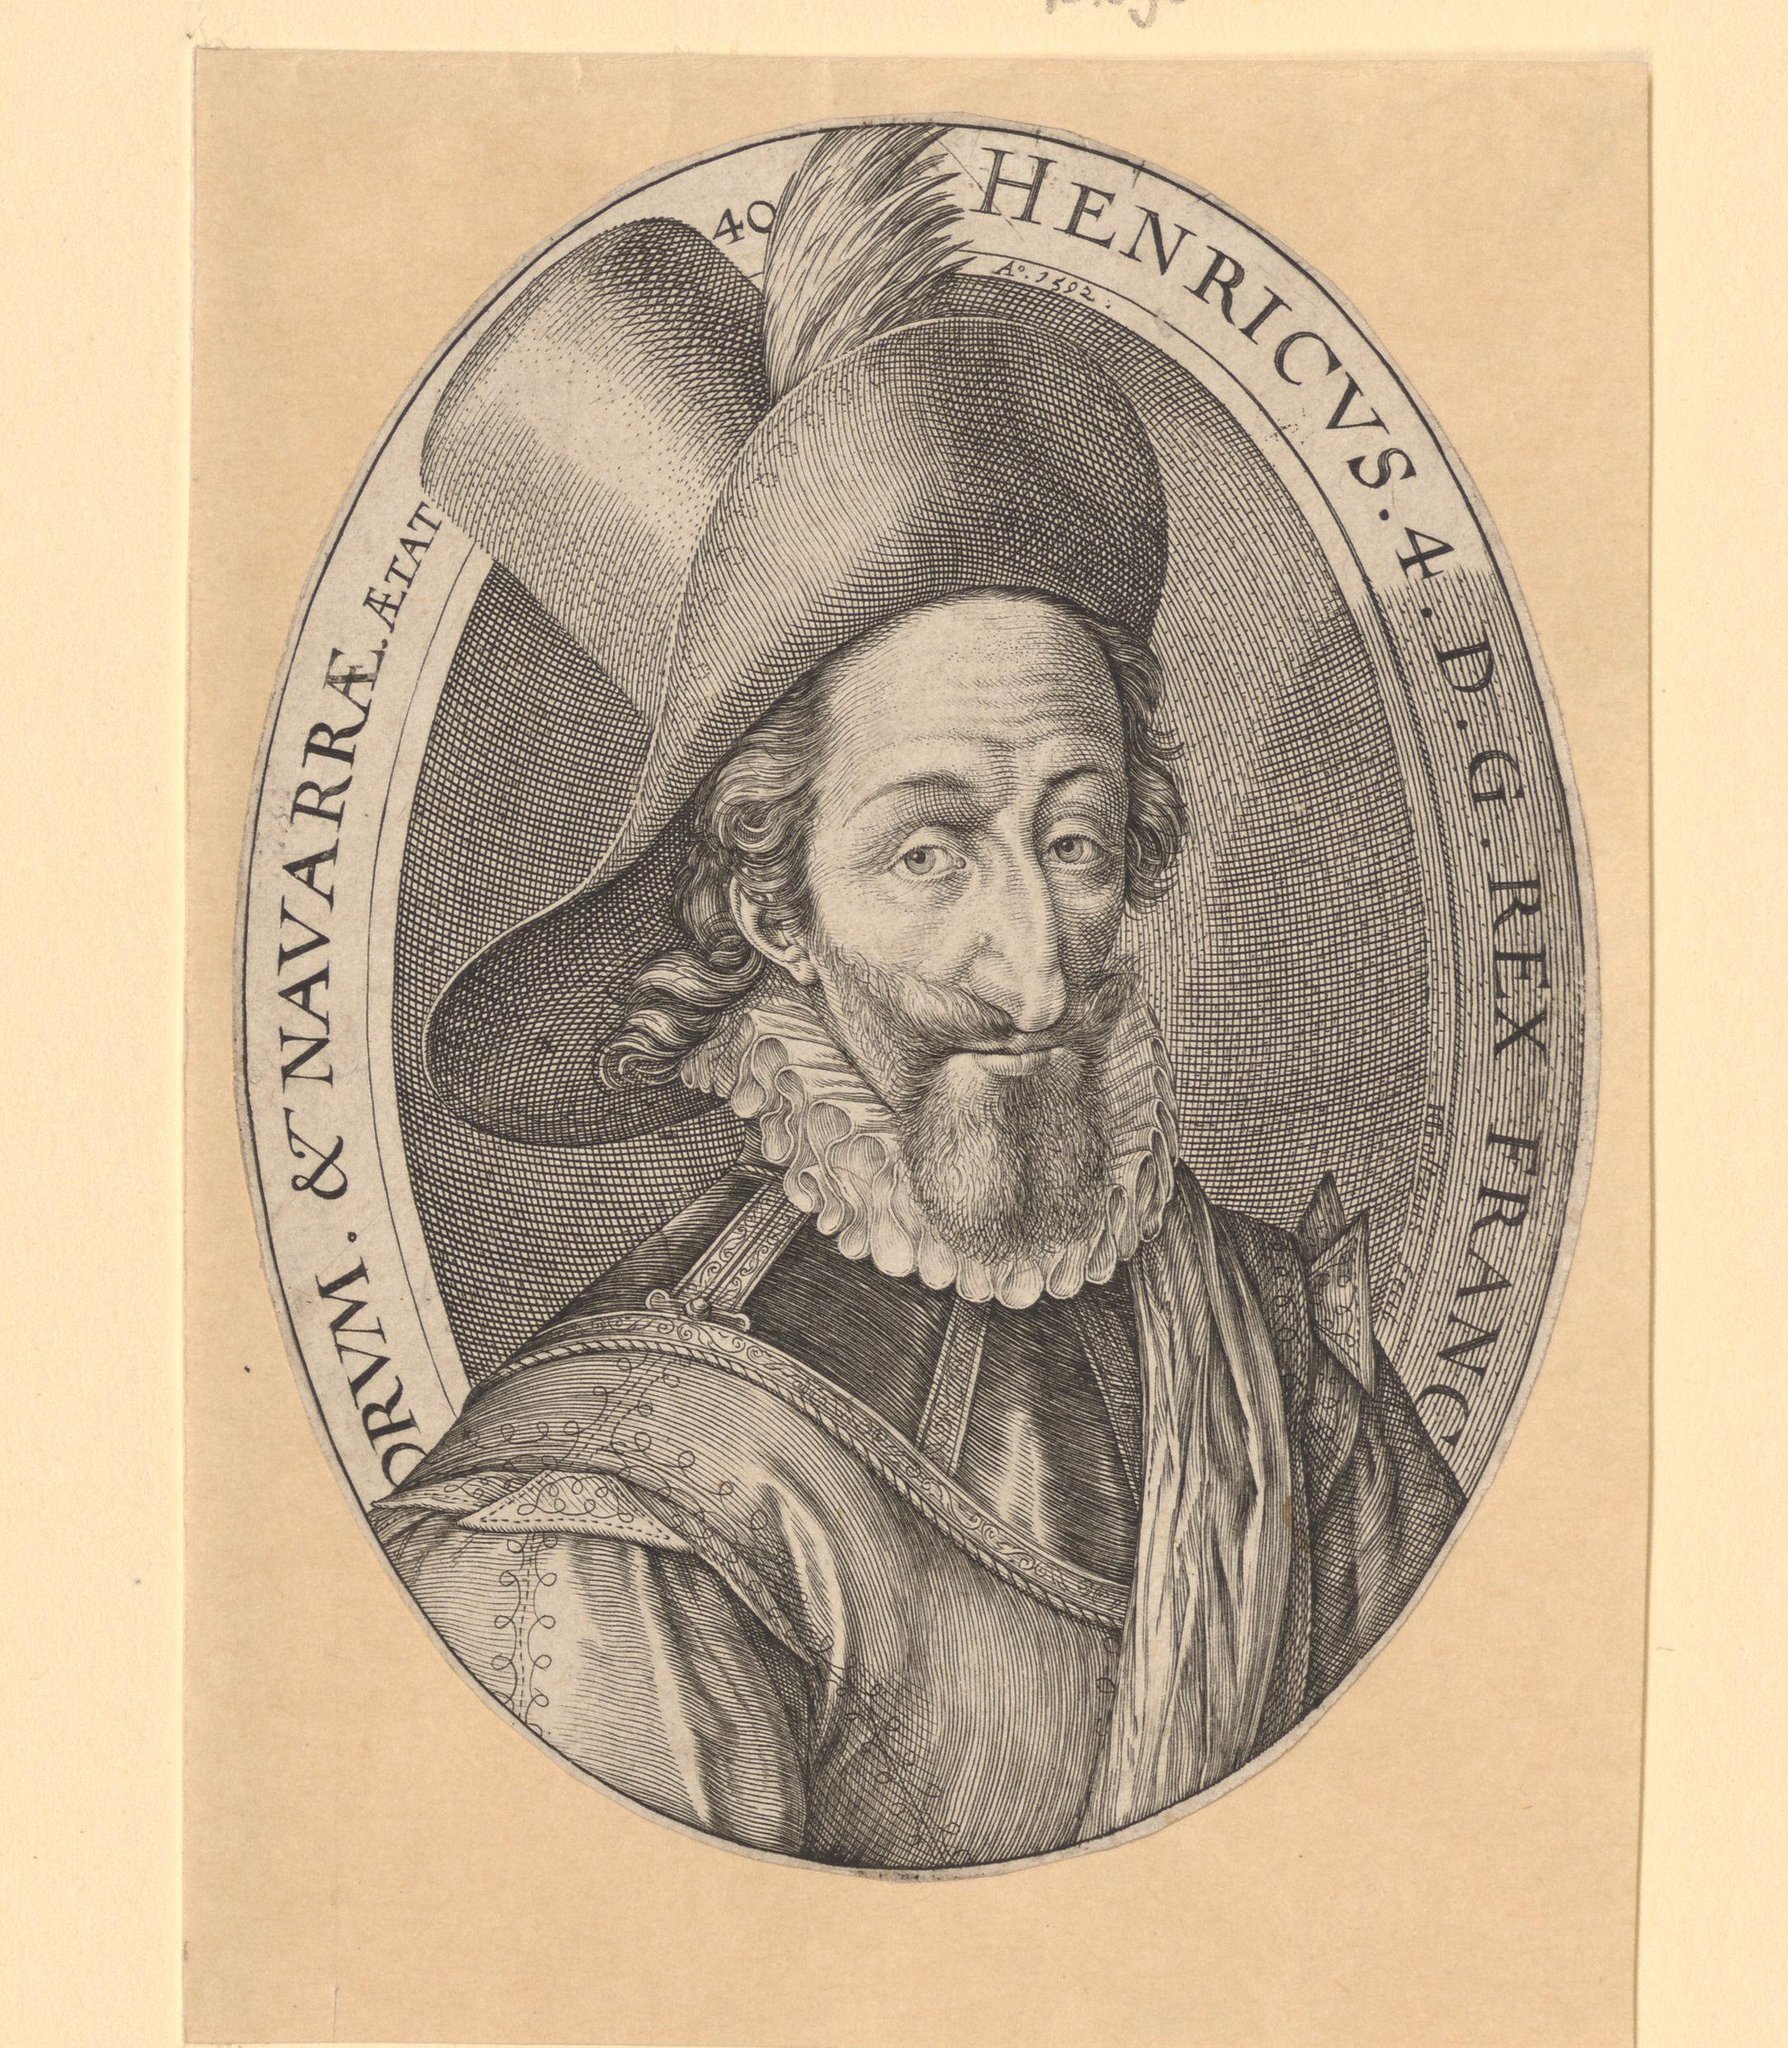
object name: print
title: Portret van Hendrik IV, koning van Frankrijk en Navarra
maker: hendrick goltzius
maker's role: draughtsman, painter, print maker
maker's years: 1558-1617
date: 1592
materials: paper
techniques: engraving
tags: paris, hendrik iv (koning van frankrijk en navarra), historical persons, king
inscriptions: date